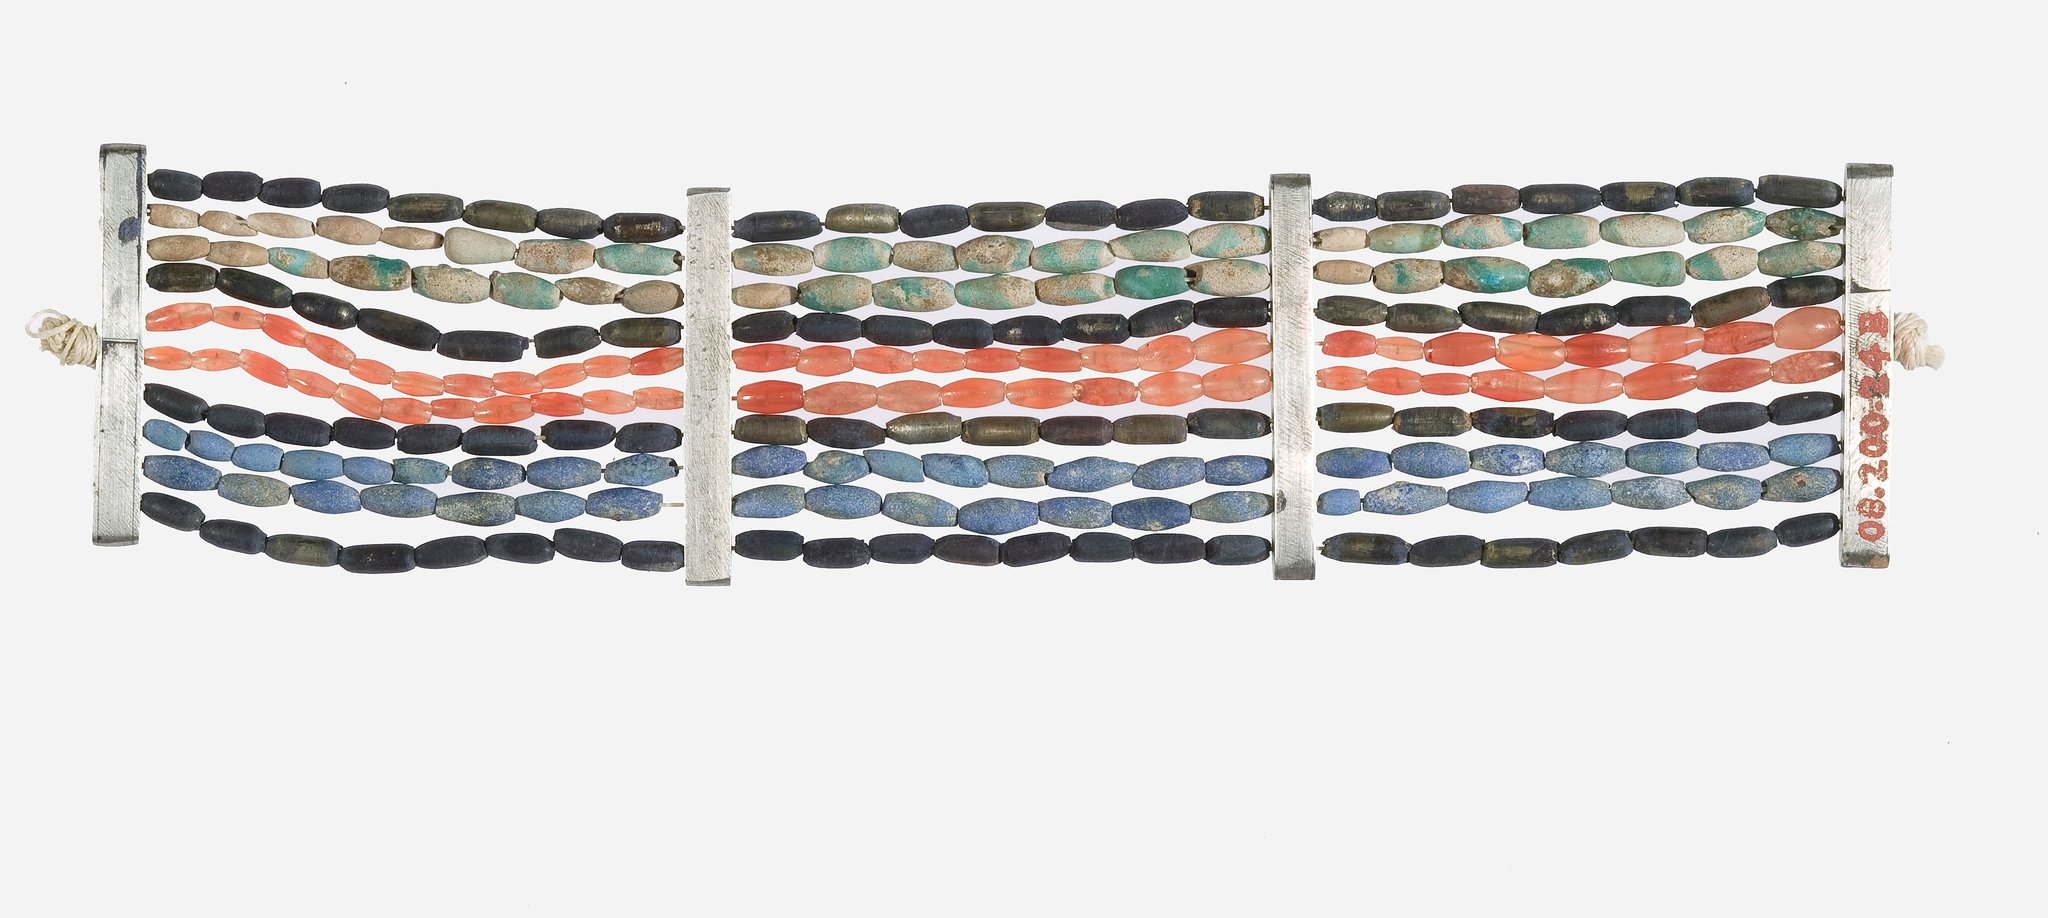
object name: bracelet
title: Pair of bracelets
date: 1850-1640 BCE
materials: gemstone, faience, paste, silver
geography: egypt